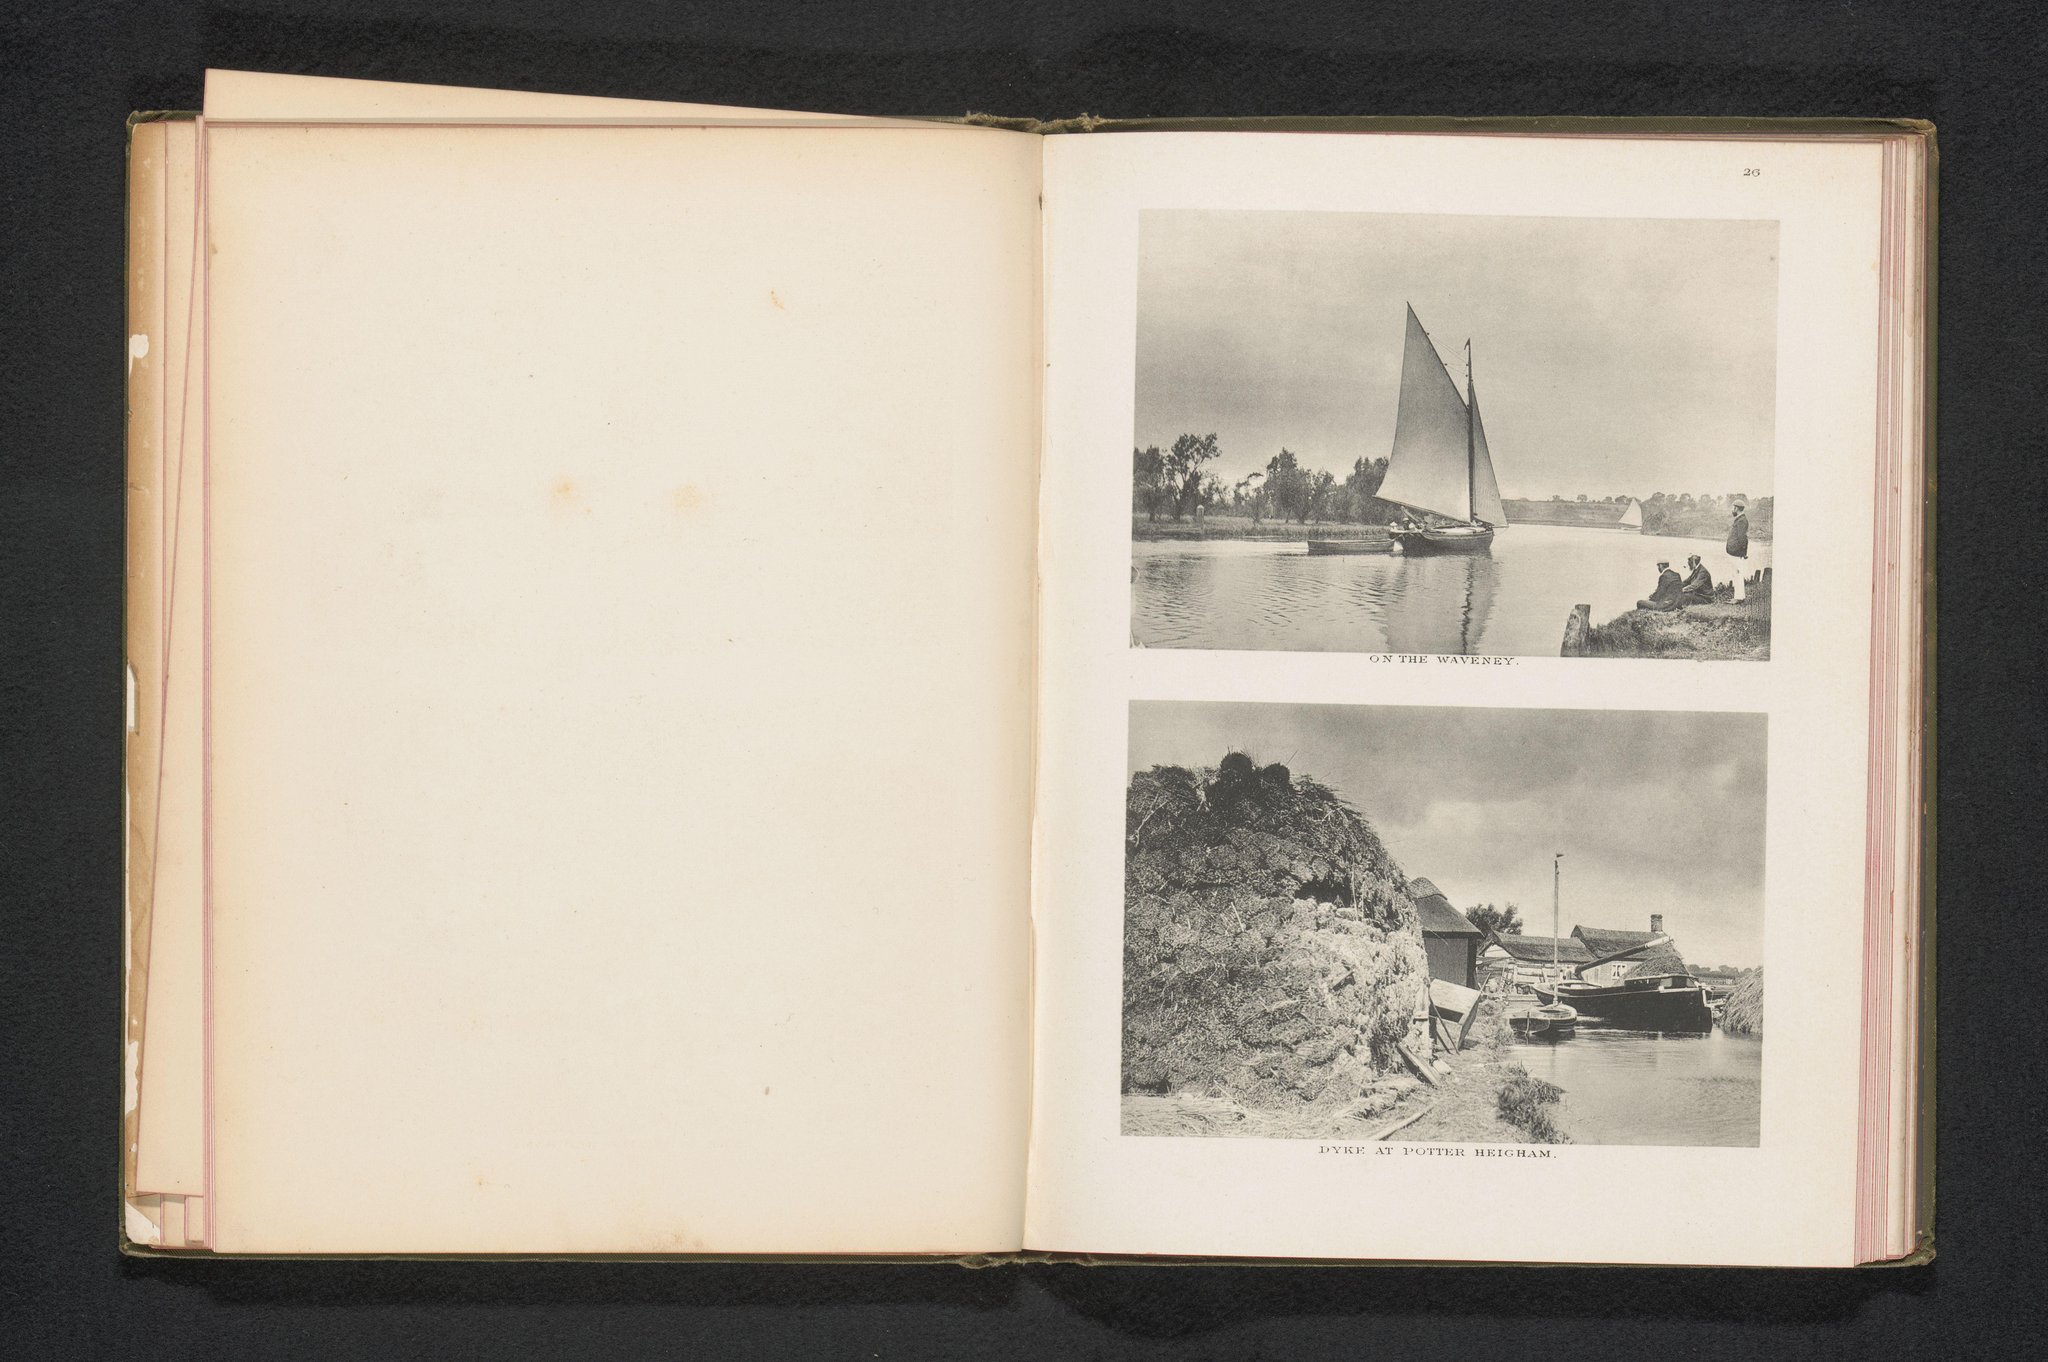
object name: page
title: Landschap nabij Potter Heigham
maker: john payne jennings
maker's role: fotograaf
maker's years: 1843-1926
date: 1886-1891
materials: paper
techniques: photograph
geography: surrey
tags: river, landscapes with waters, waterscapes, seascapes (in the temperate zone)